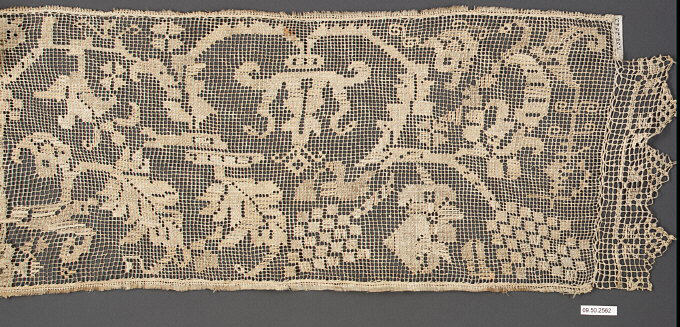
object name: fragment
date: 1701-1800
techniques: embroidery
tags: leaves